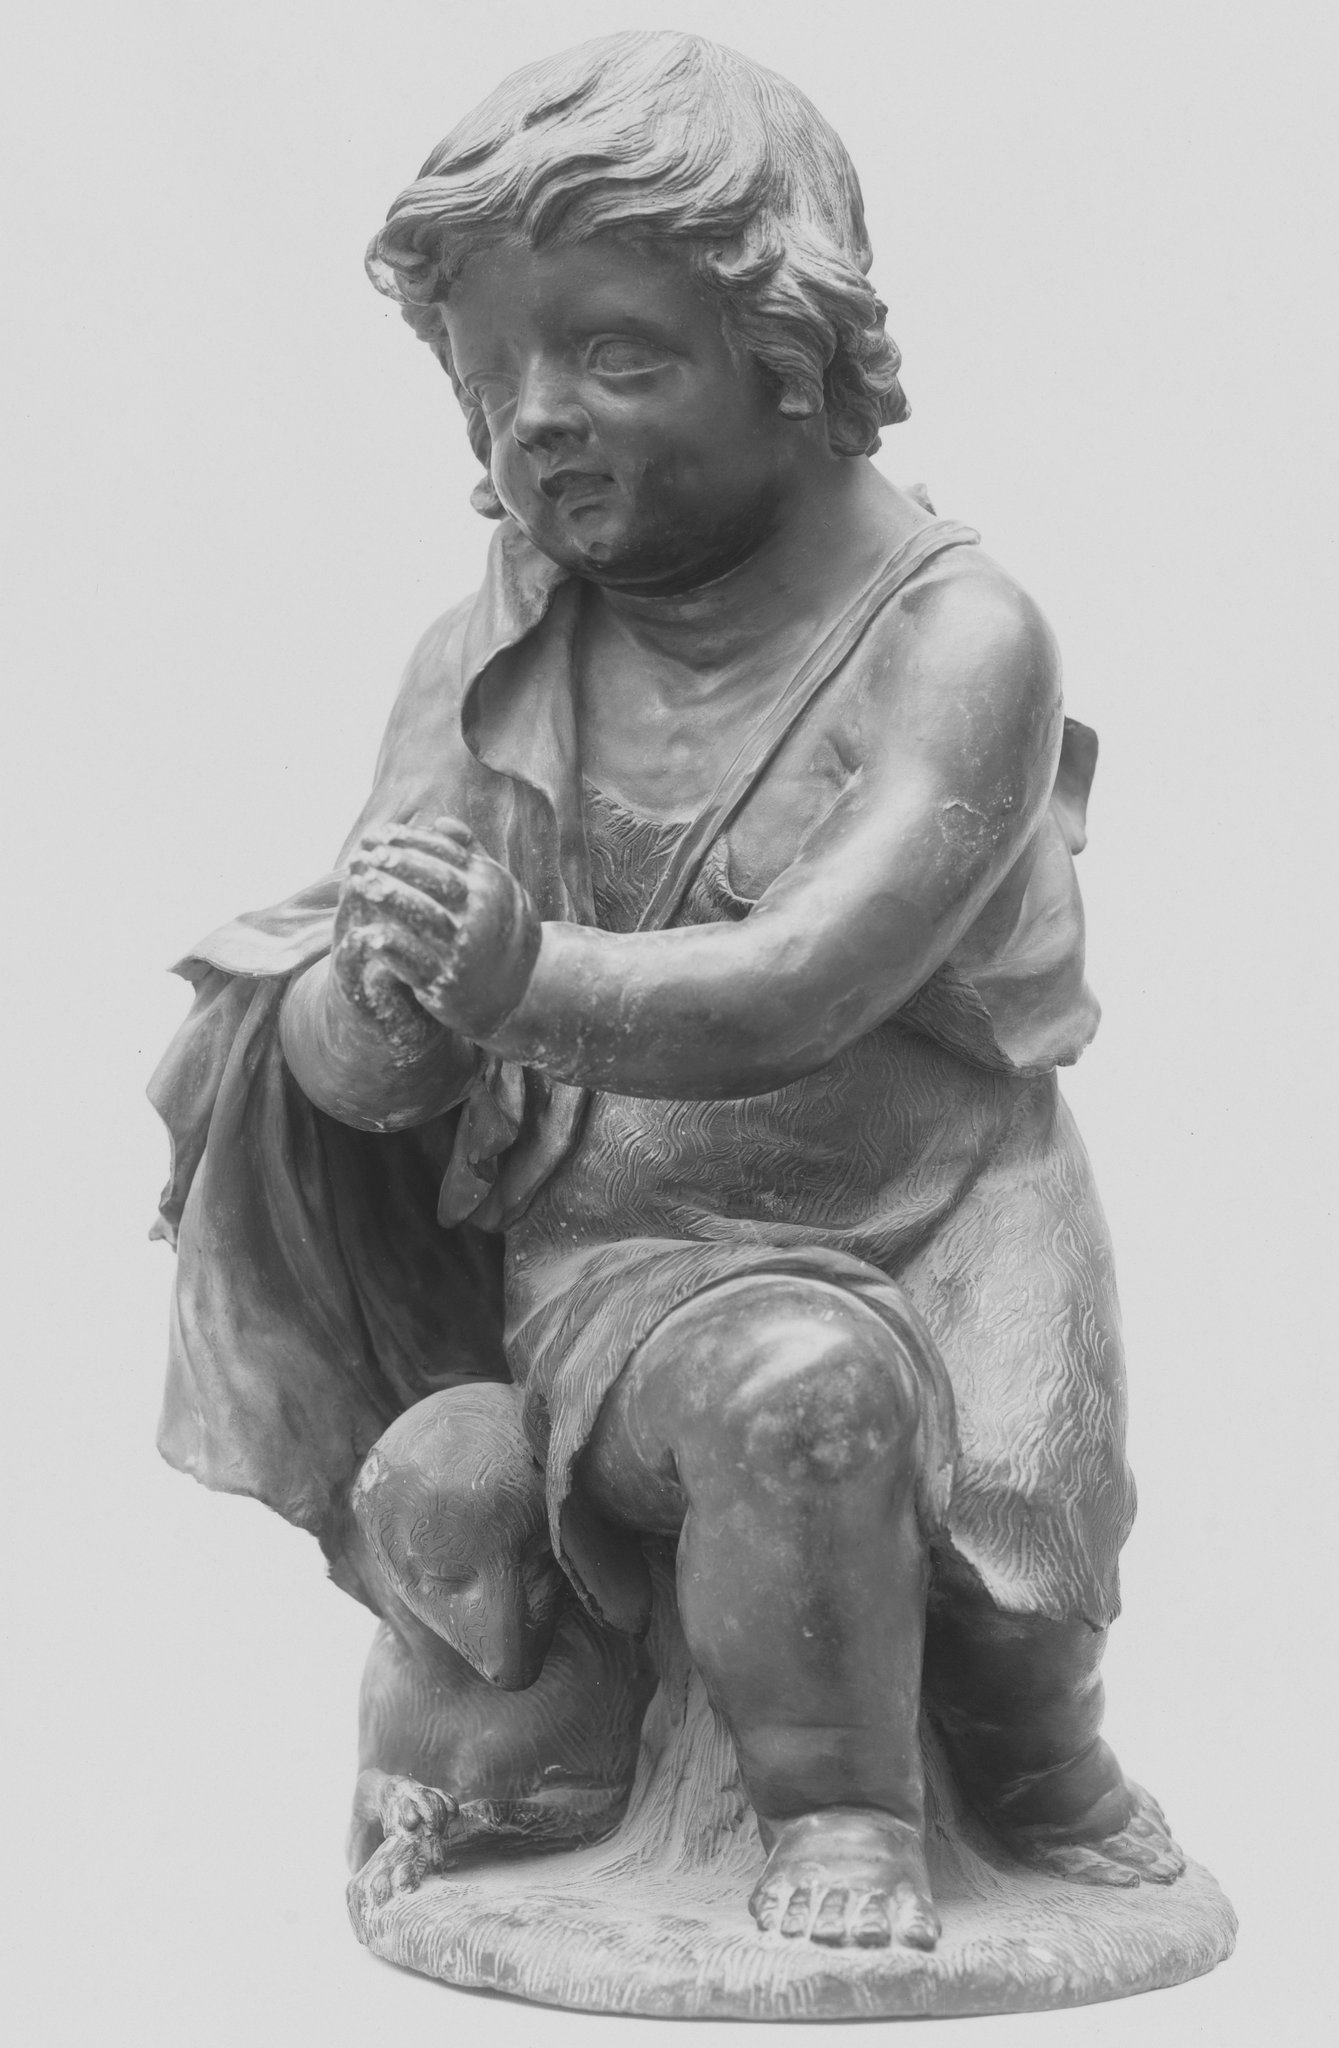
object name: statuette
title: Saint John the Baptist as a child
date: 1601-1700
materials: terracotta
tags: boys,saint john the baptist